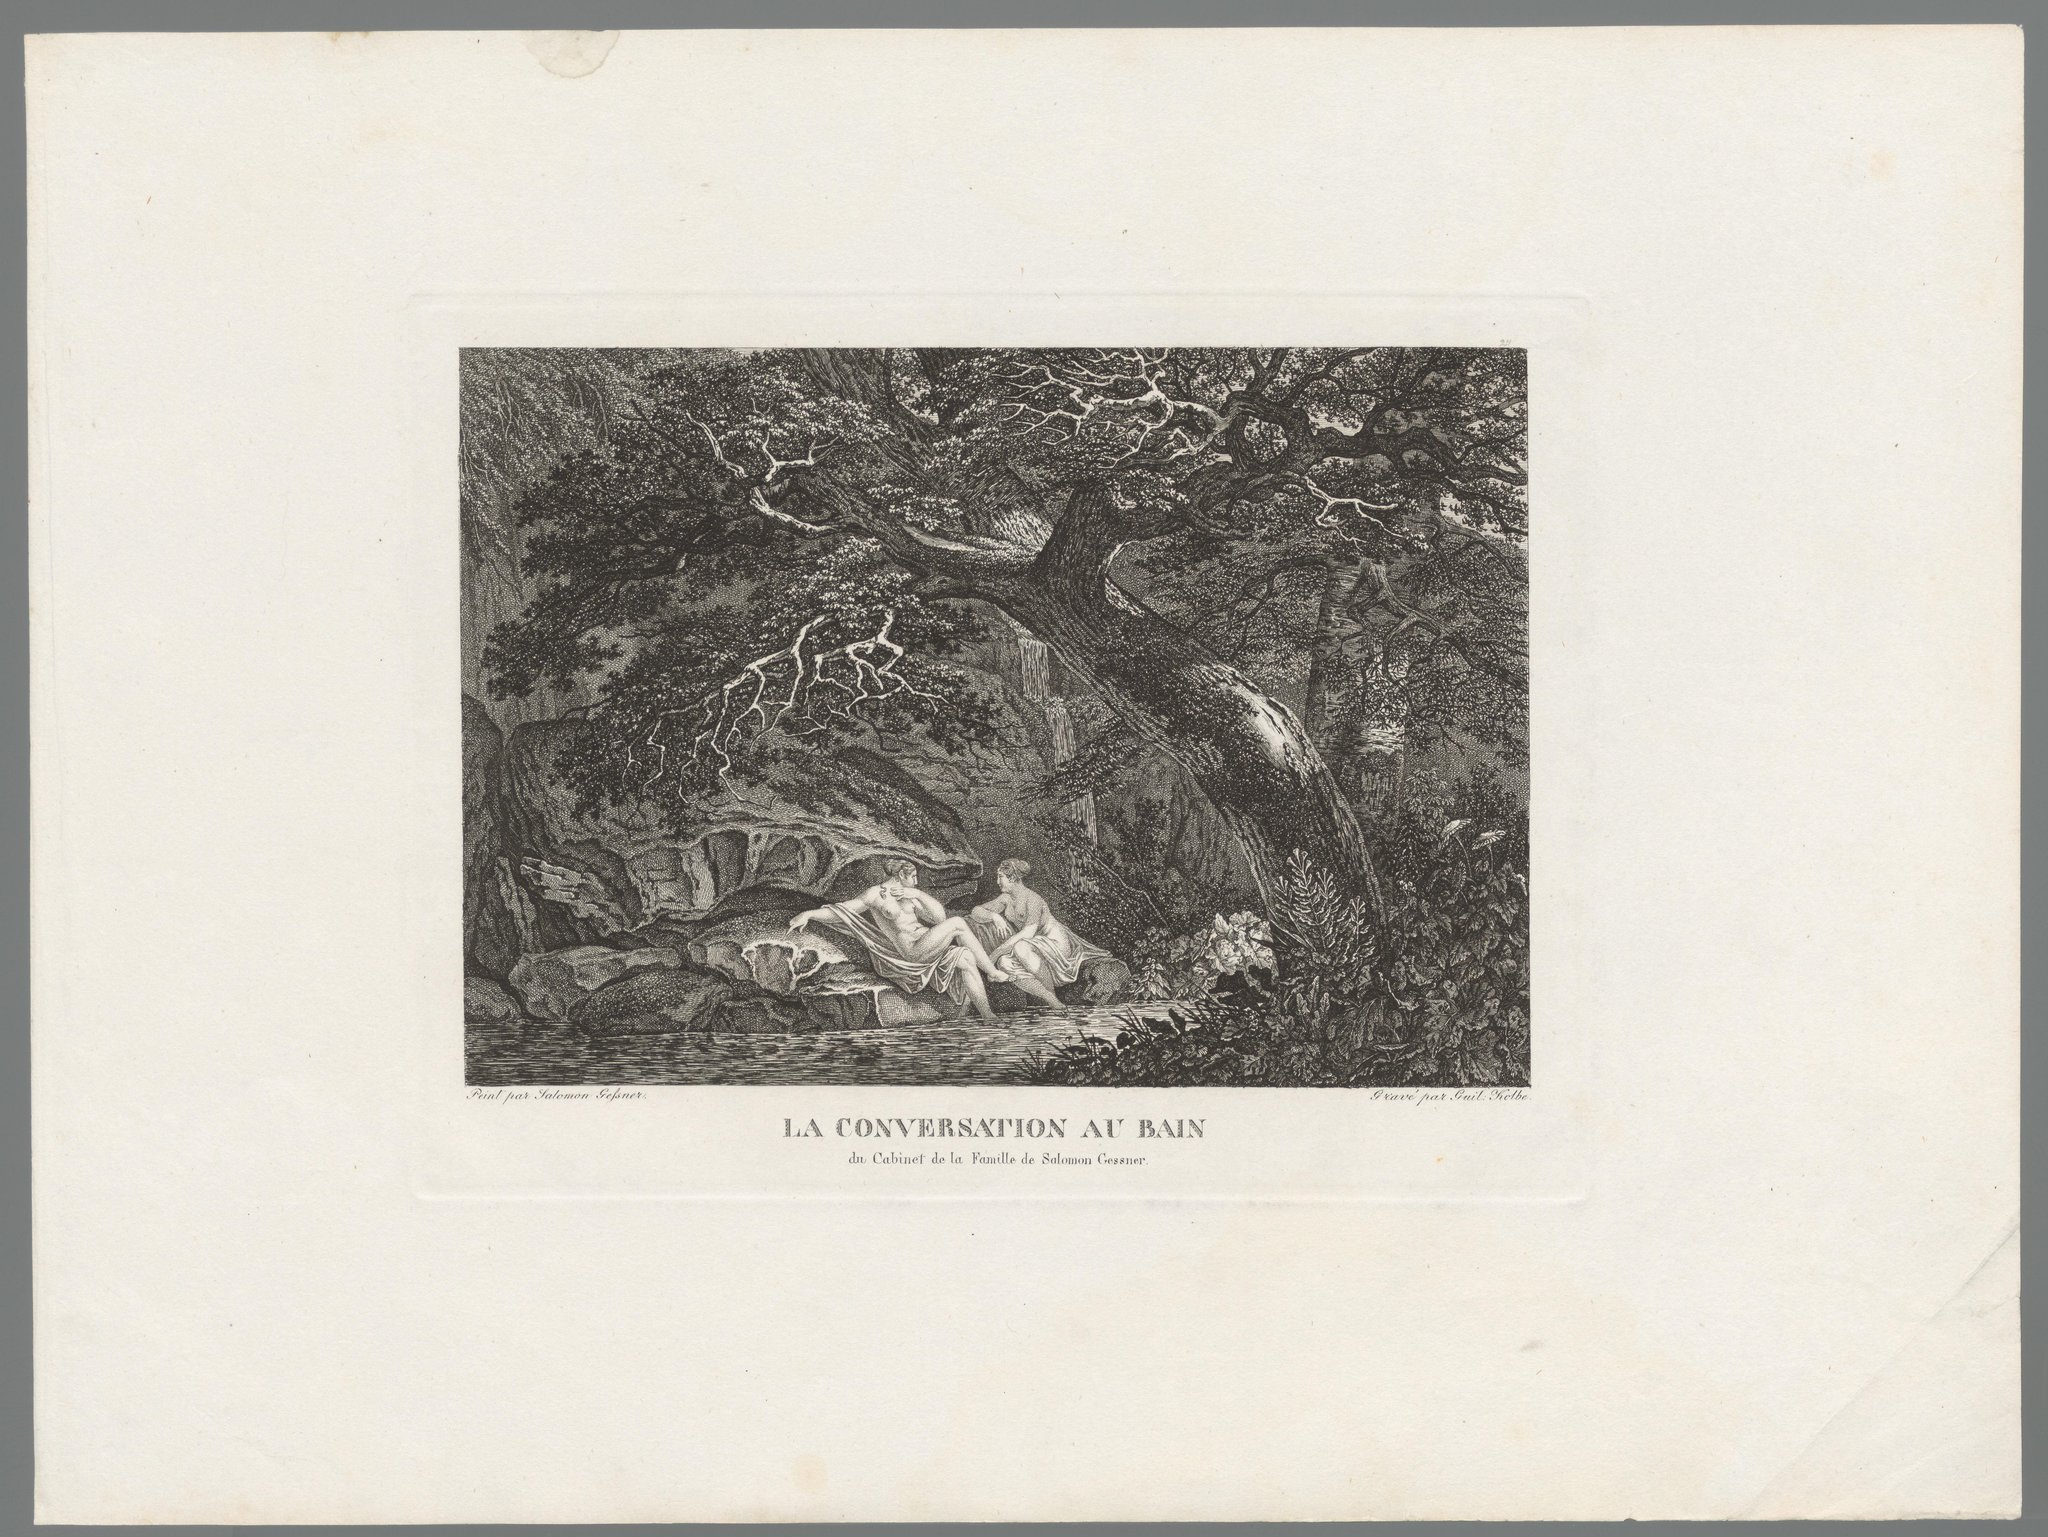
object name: print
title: La conversation au bain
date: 1811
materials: paper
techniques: etching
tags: waterfall, taking a bath - aa - in the open air, pastorals, arcadian scenes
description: Deze prent is gemaakt voor een serie uit 1811 getiteld: Collection des tableaux en gouache et des dessins de Salomon Gessner. Gravés à l'eau forte par Guil. Kolbe. De gehele serie is in het bezit van het RMA onder inv. nr. RP-P-2005-184.